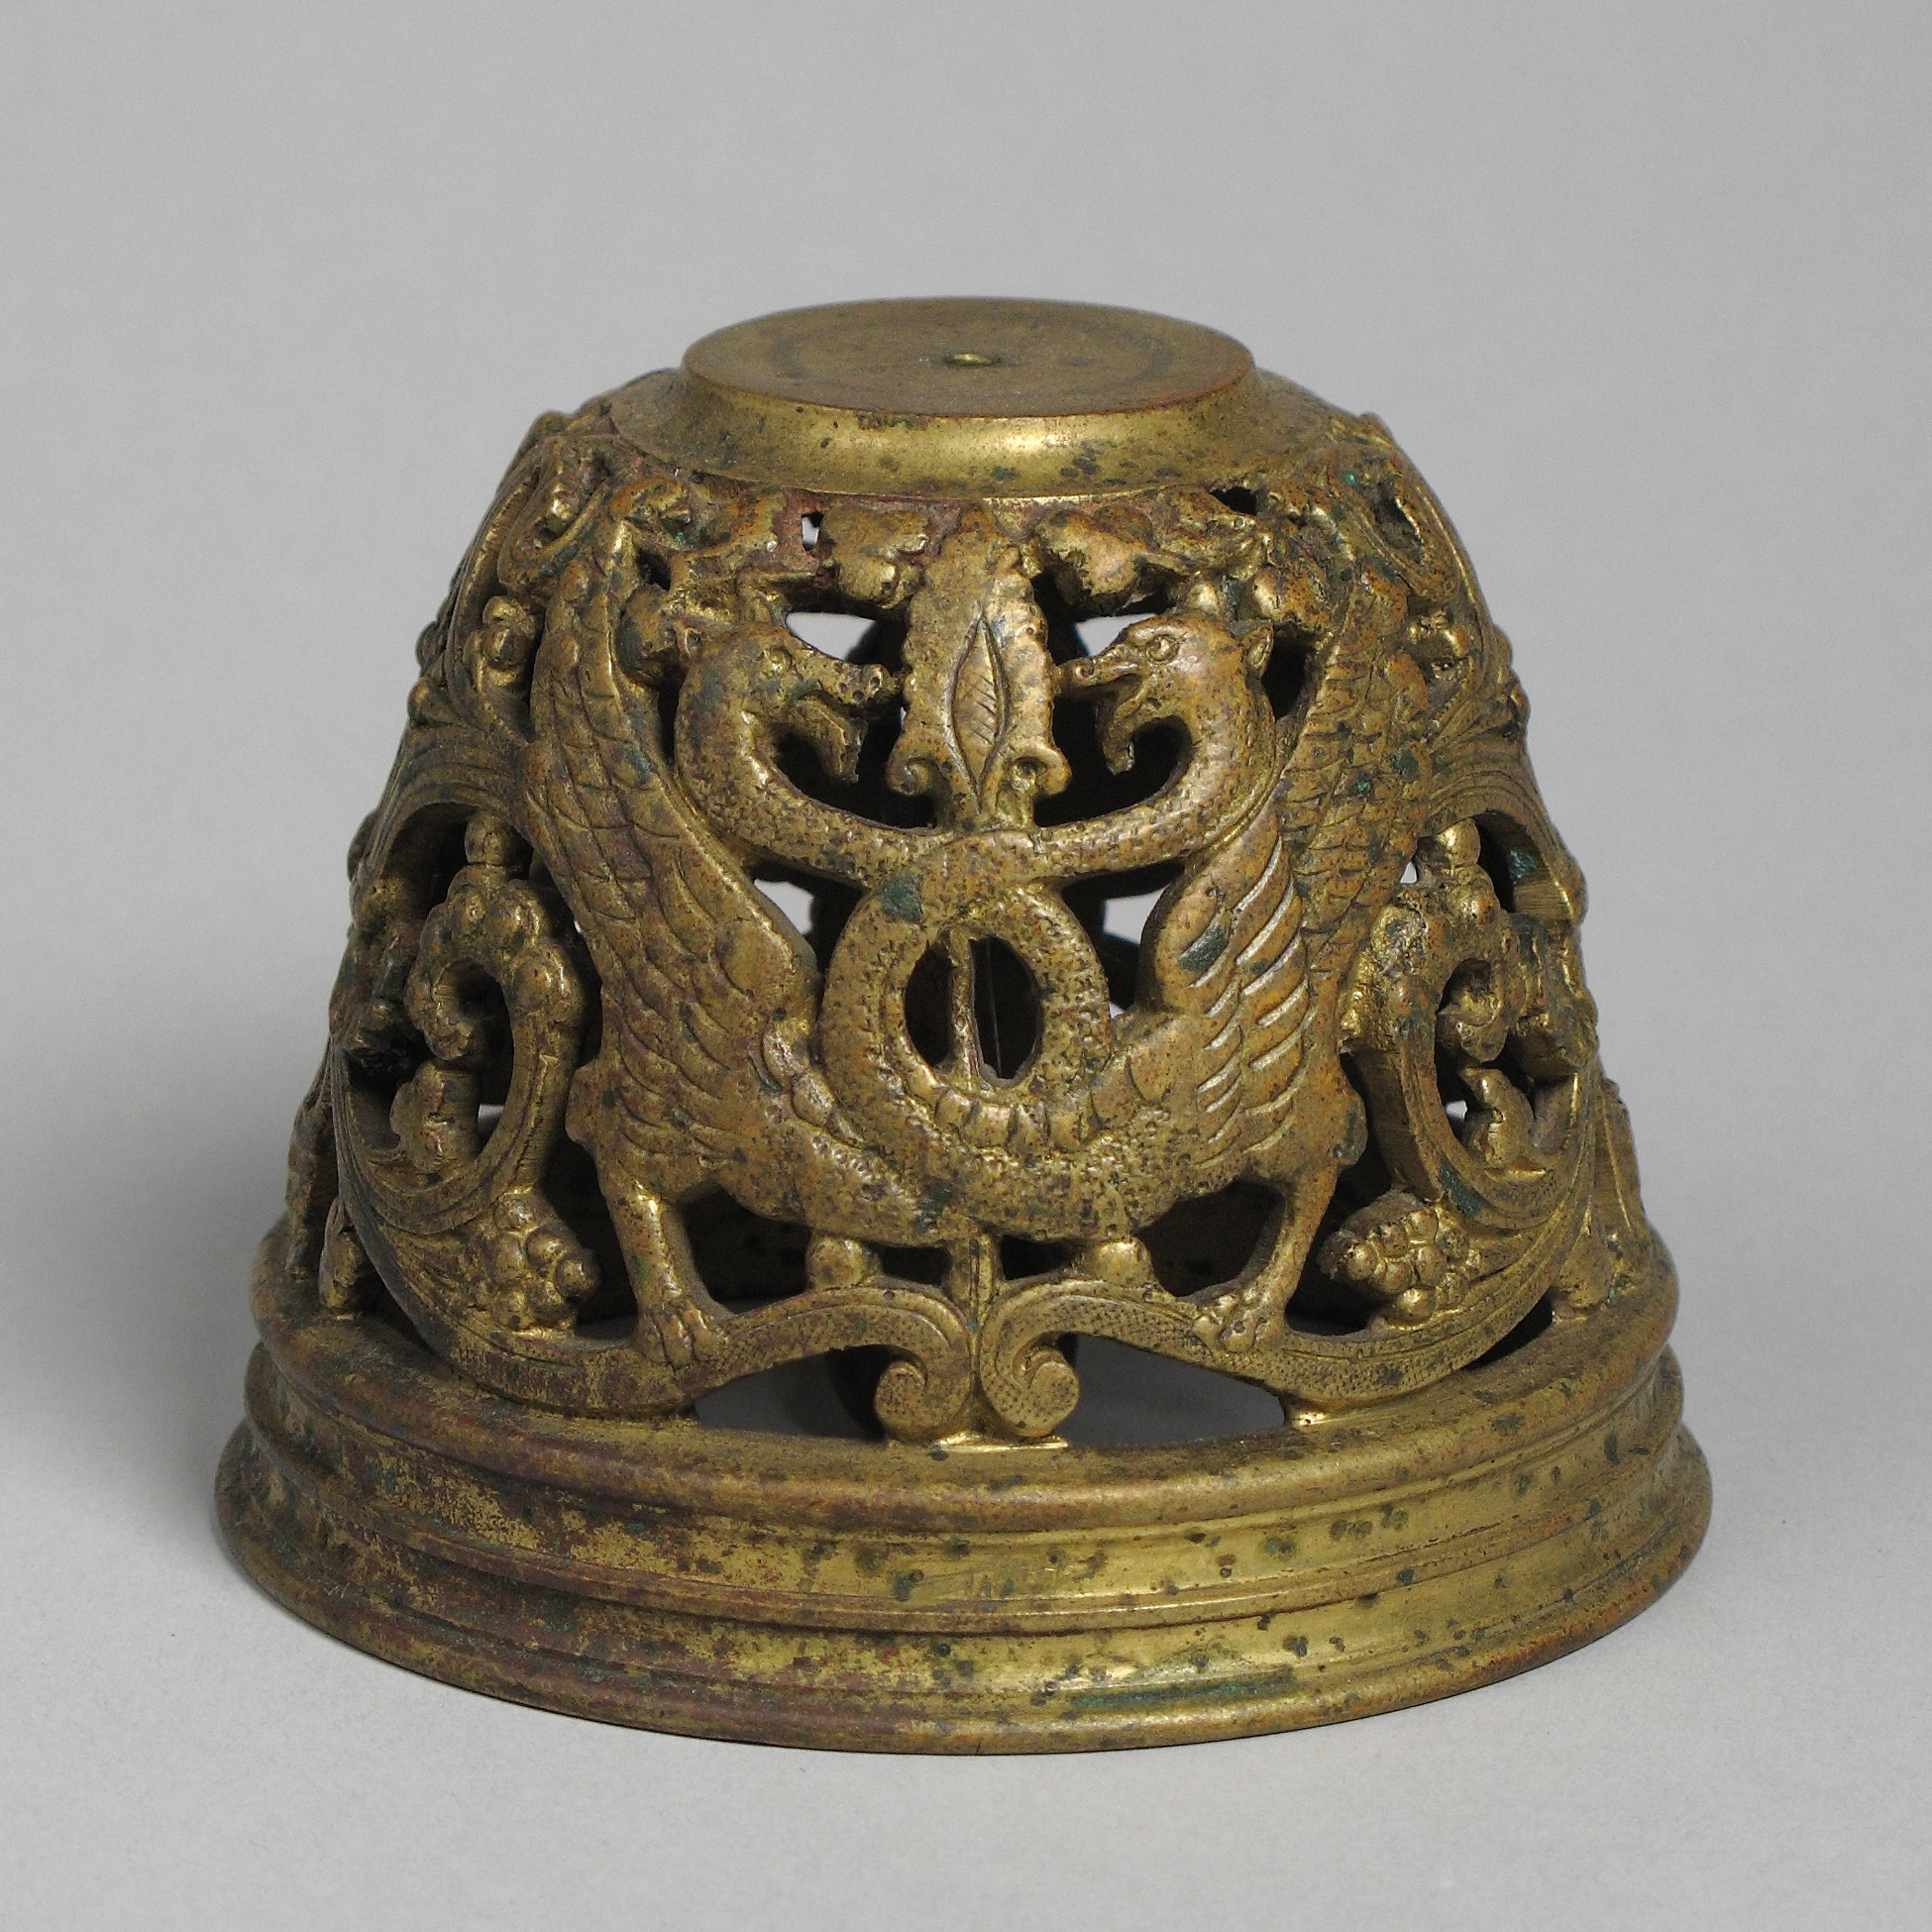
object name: bell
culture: french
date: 1101-1200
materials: bronze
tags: griffins